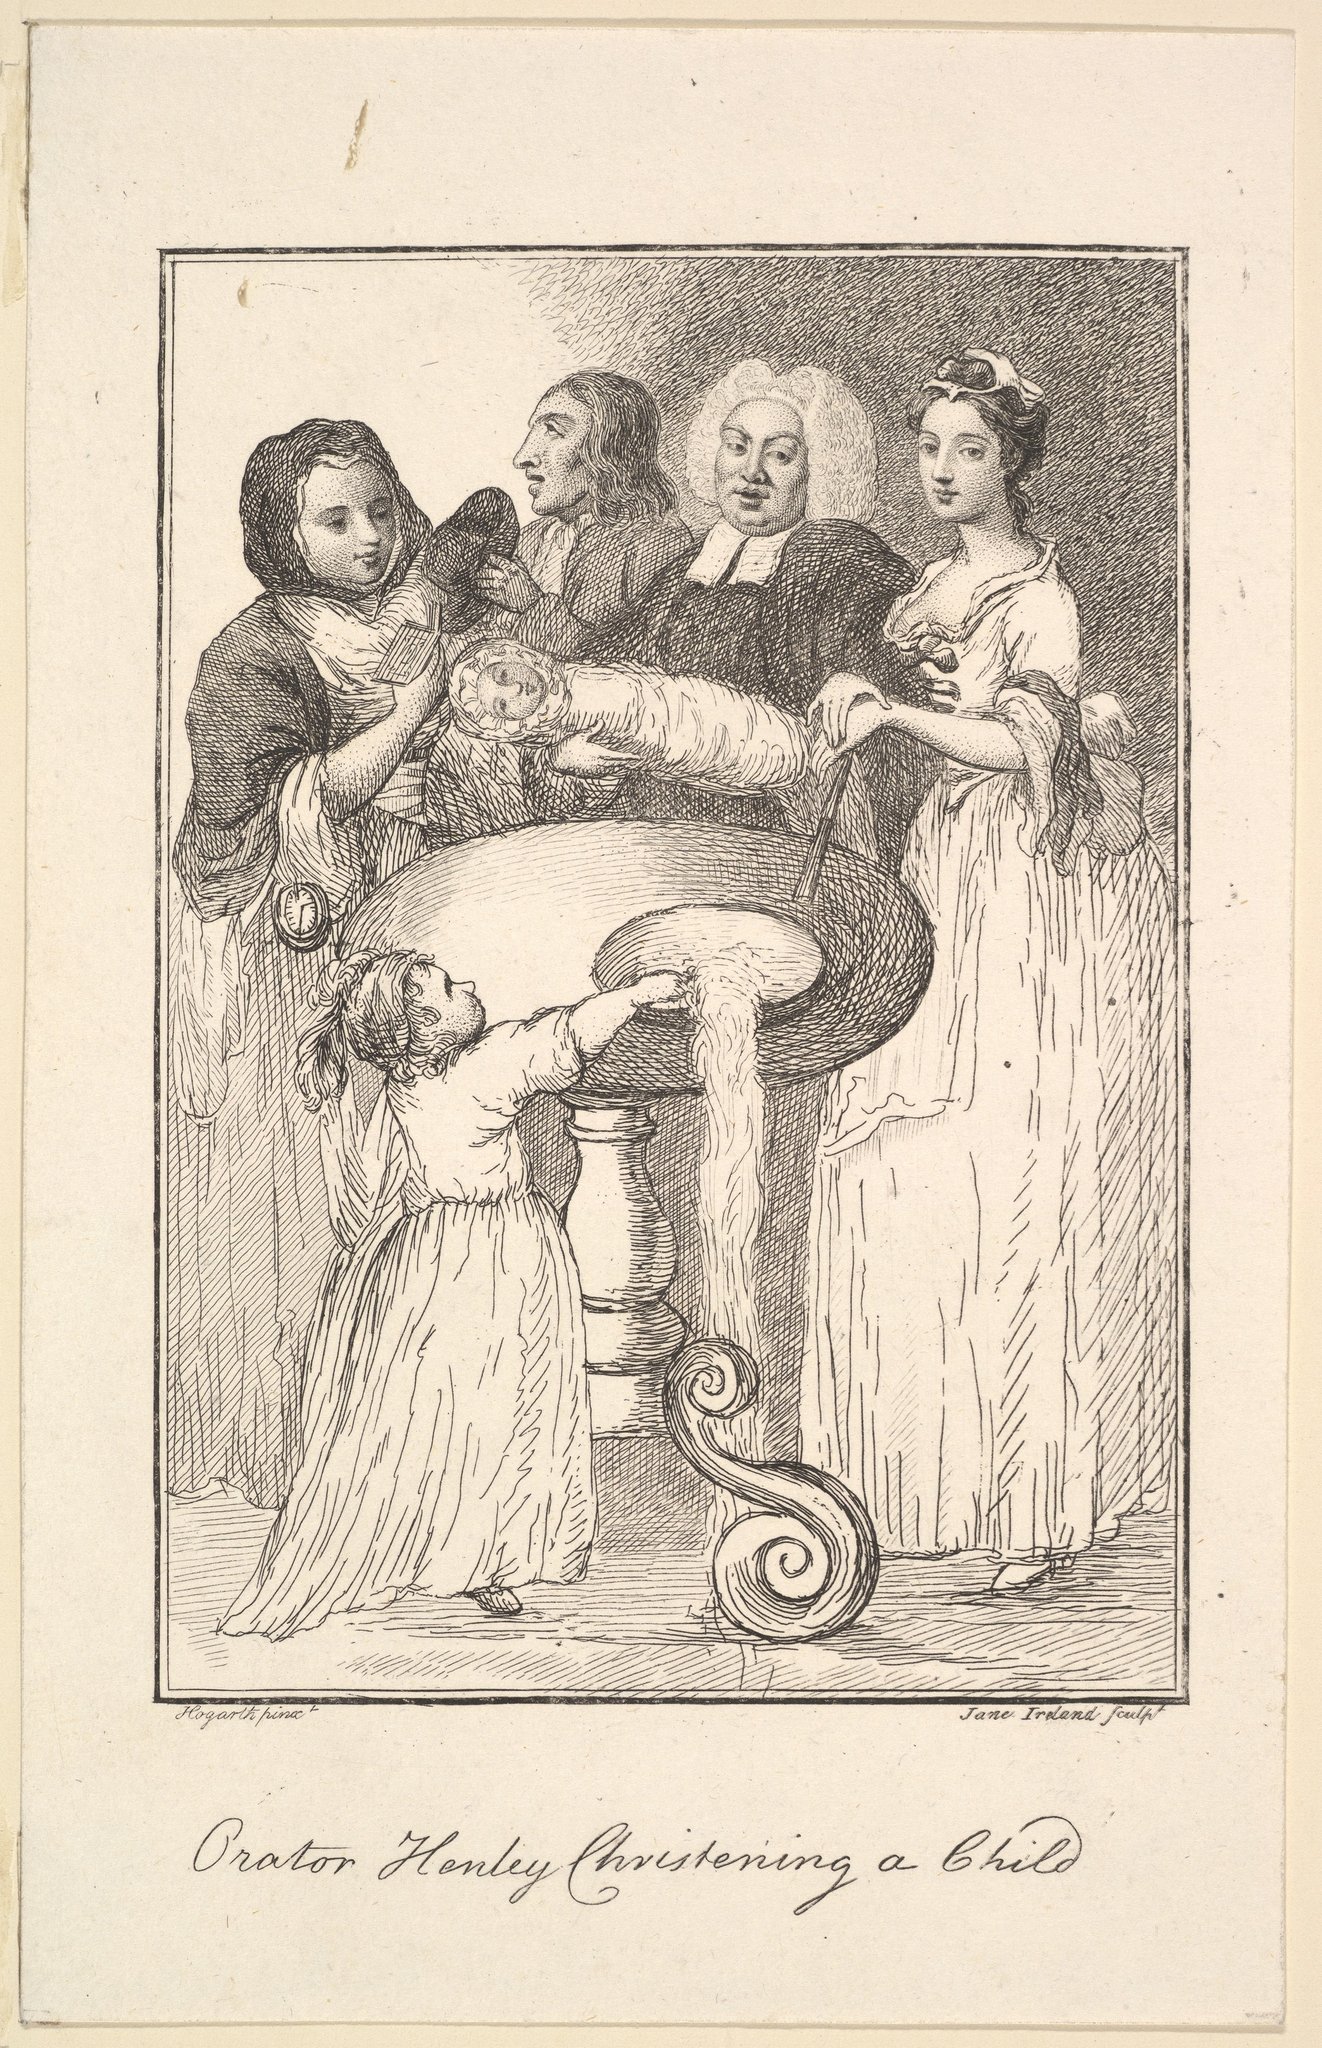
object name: print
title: Orator Henley Christening a Child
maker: jane ireland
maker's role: etcher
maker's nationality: british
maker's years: 1790-1800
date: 1794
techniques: etching, stippling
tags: infants,men,women